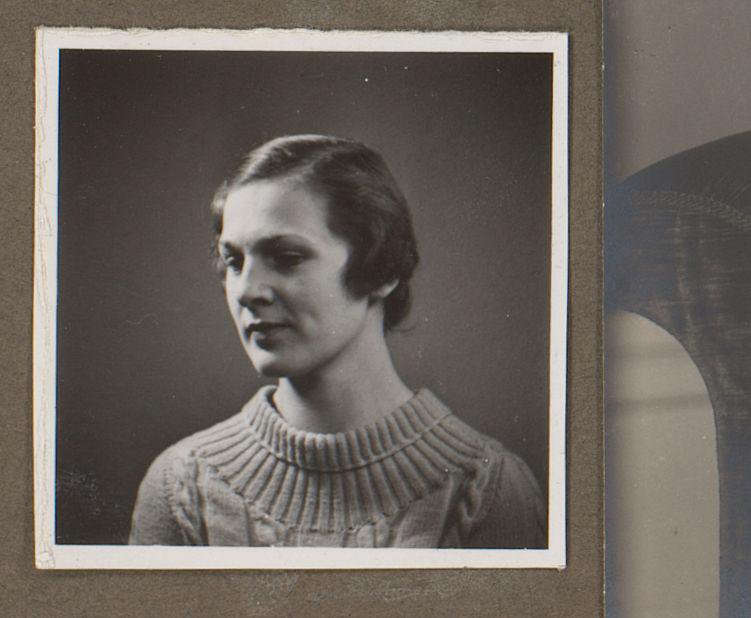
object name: album leaf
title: Portret van Corry Mak van Waay-Zulver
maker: Anonymous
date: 1934-1935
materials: paper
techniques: gelatin silver print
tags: historical persons - bb - woman